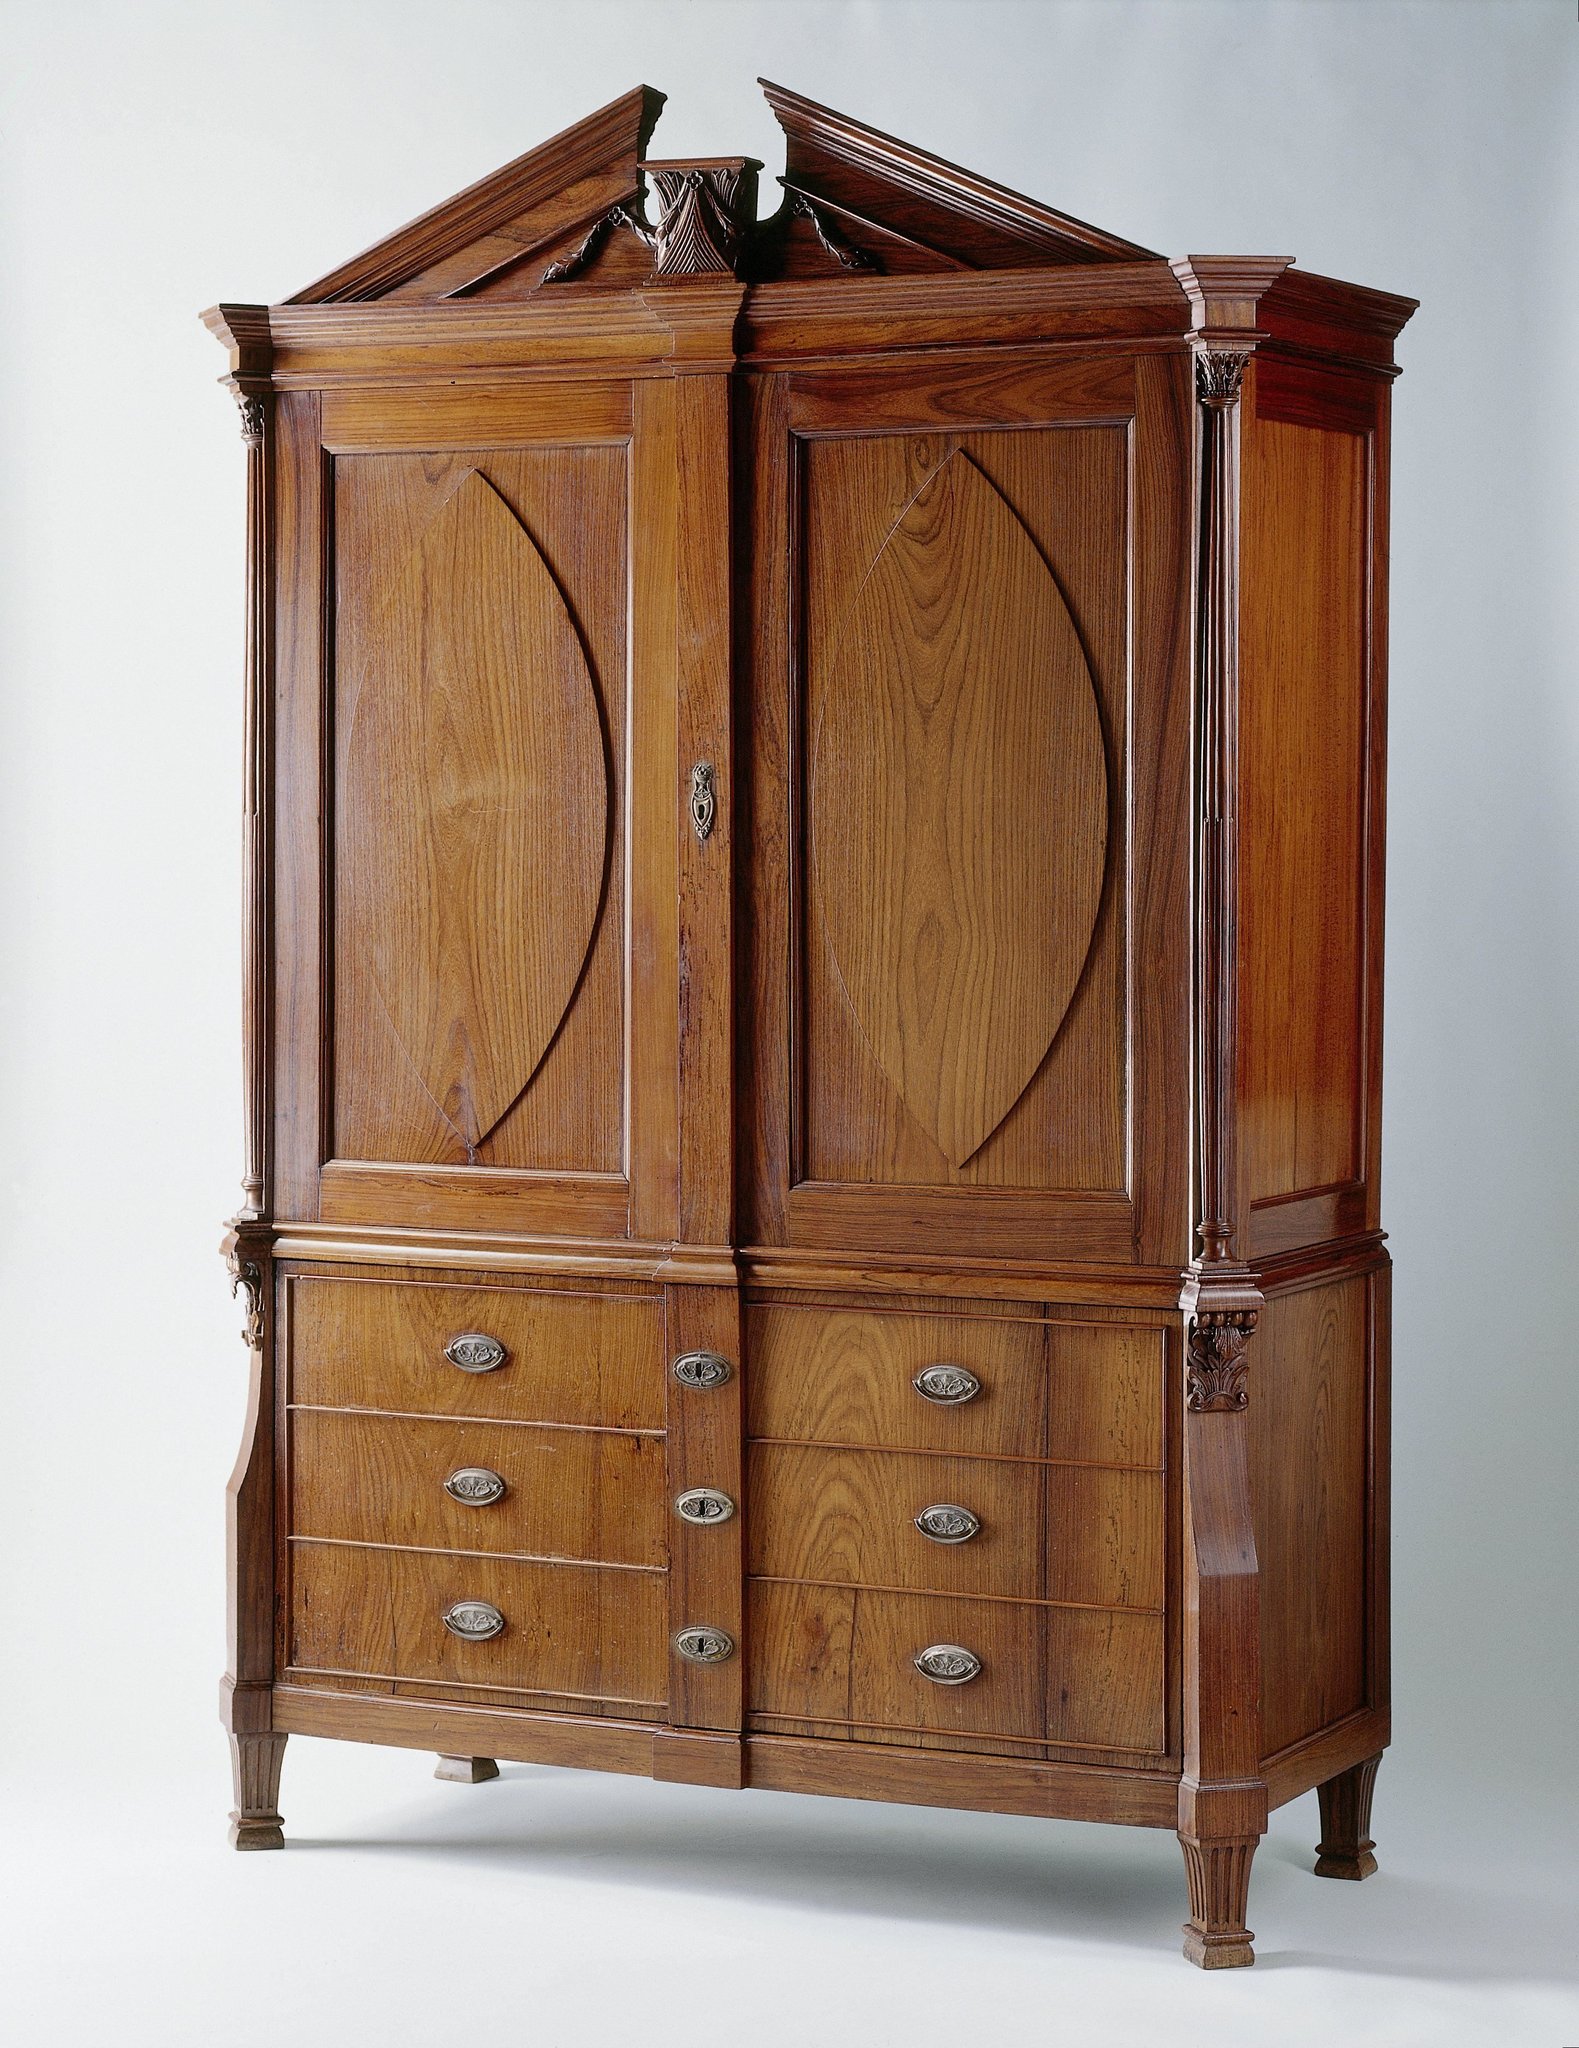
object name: cabinet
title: Kabinet van tropisch hout met in deuren spitsovaal van ebbenhout en boven deuren fronton met vaas en lauwerslinger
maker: Anonymous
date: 1800-1810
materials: wood, silver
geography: indonesia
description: Kabinet van tropisch hout (sono keling?) ingelegd met ebbenhout, met beslag van zilver. Het rechthoekige meubel is verdeeld in een onder- en een bovenkast. De onderkast heeft twee dueren, behandeld als twee x drie laden, gescheiden door een middenstijl, en overhoeks geplaatste hoekstijlen op conische, zich verjongende poten. De bovenkast heeft twee deuren waarachter planken. De rechterdeur wordt afgesloten door de middenstijl. Beide deuren hebben een verdiept paneel ingelegd met een spitsovaal in ebbenhout. Op de beide voorste hoeken van de bovenkast overhoeks geplaatste Corinthische pilasters. De kast wordt bekroond door een fronton, in het midden doorbroken door een vaas op een voetstuk waarvan een lauwerslinger afhangt. Slotplaten en trekkers van zilver.